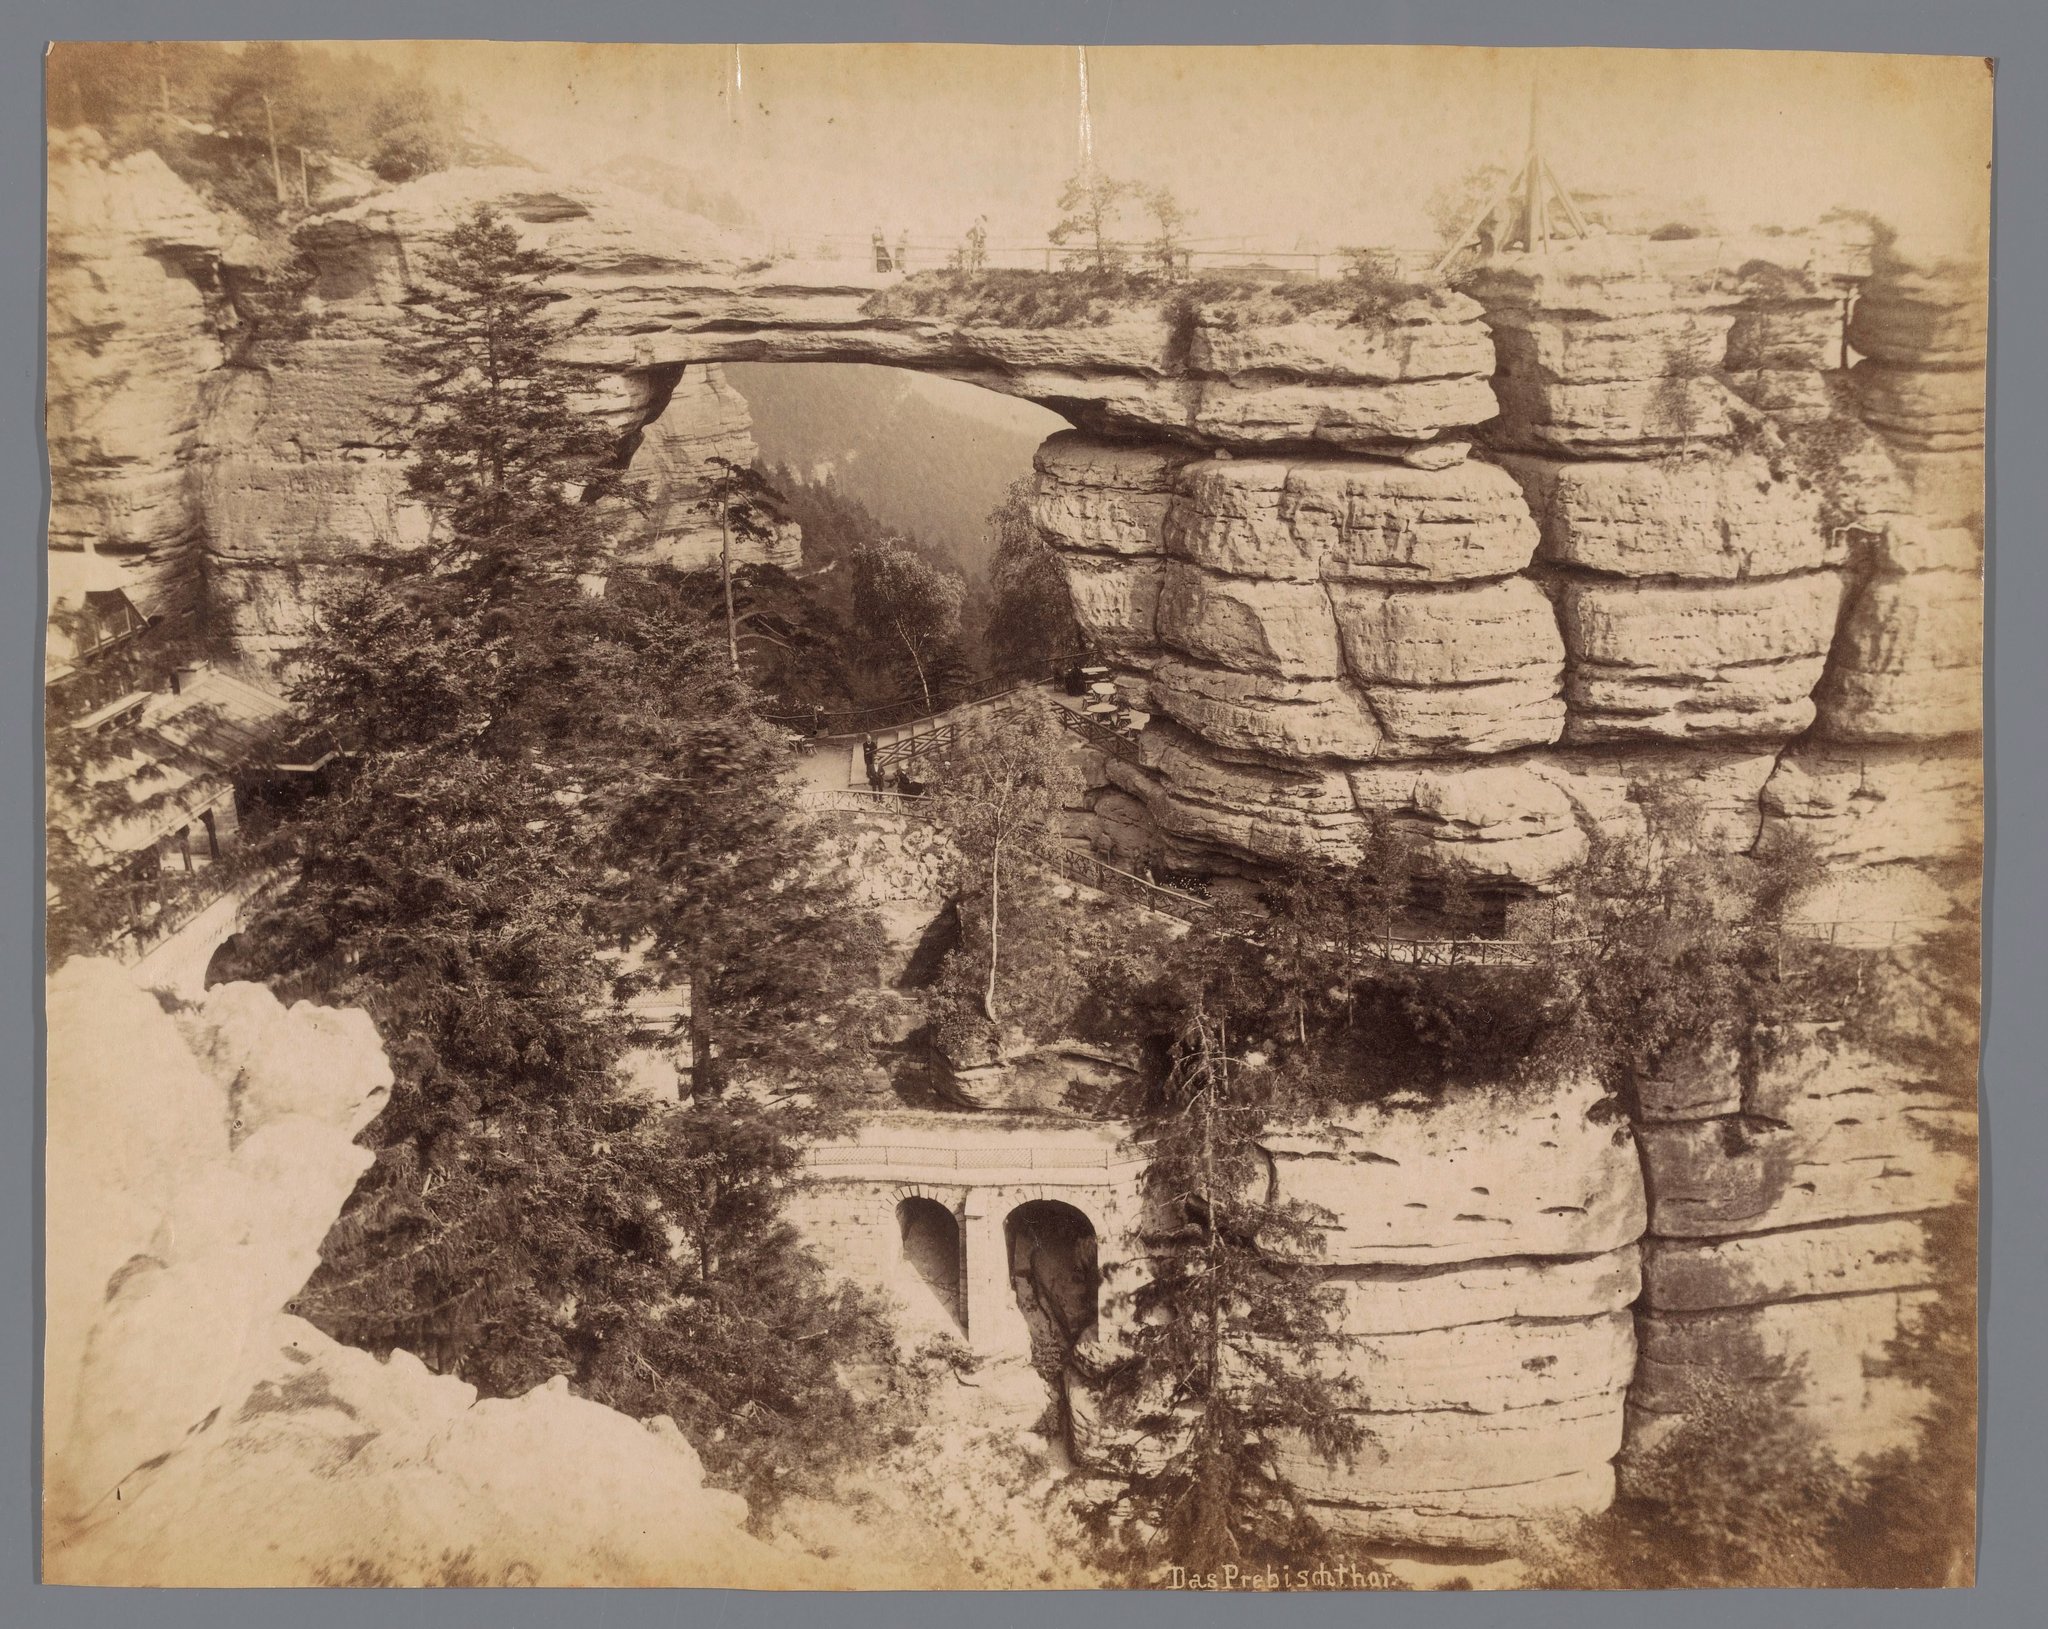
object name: photograph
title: Zandsteenbrug Pravcická Brána in Boheems Zwitserland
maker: Anonymous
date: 1881-1910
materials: paper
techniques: albumen print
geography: bohemian switzerland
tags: rock-formations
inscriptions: inscription: ‘Das Prebischthor.’